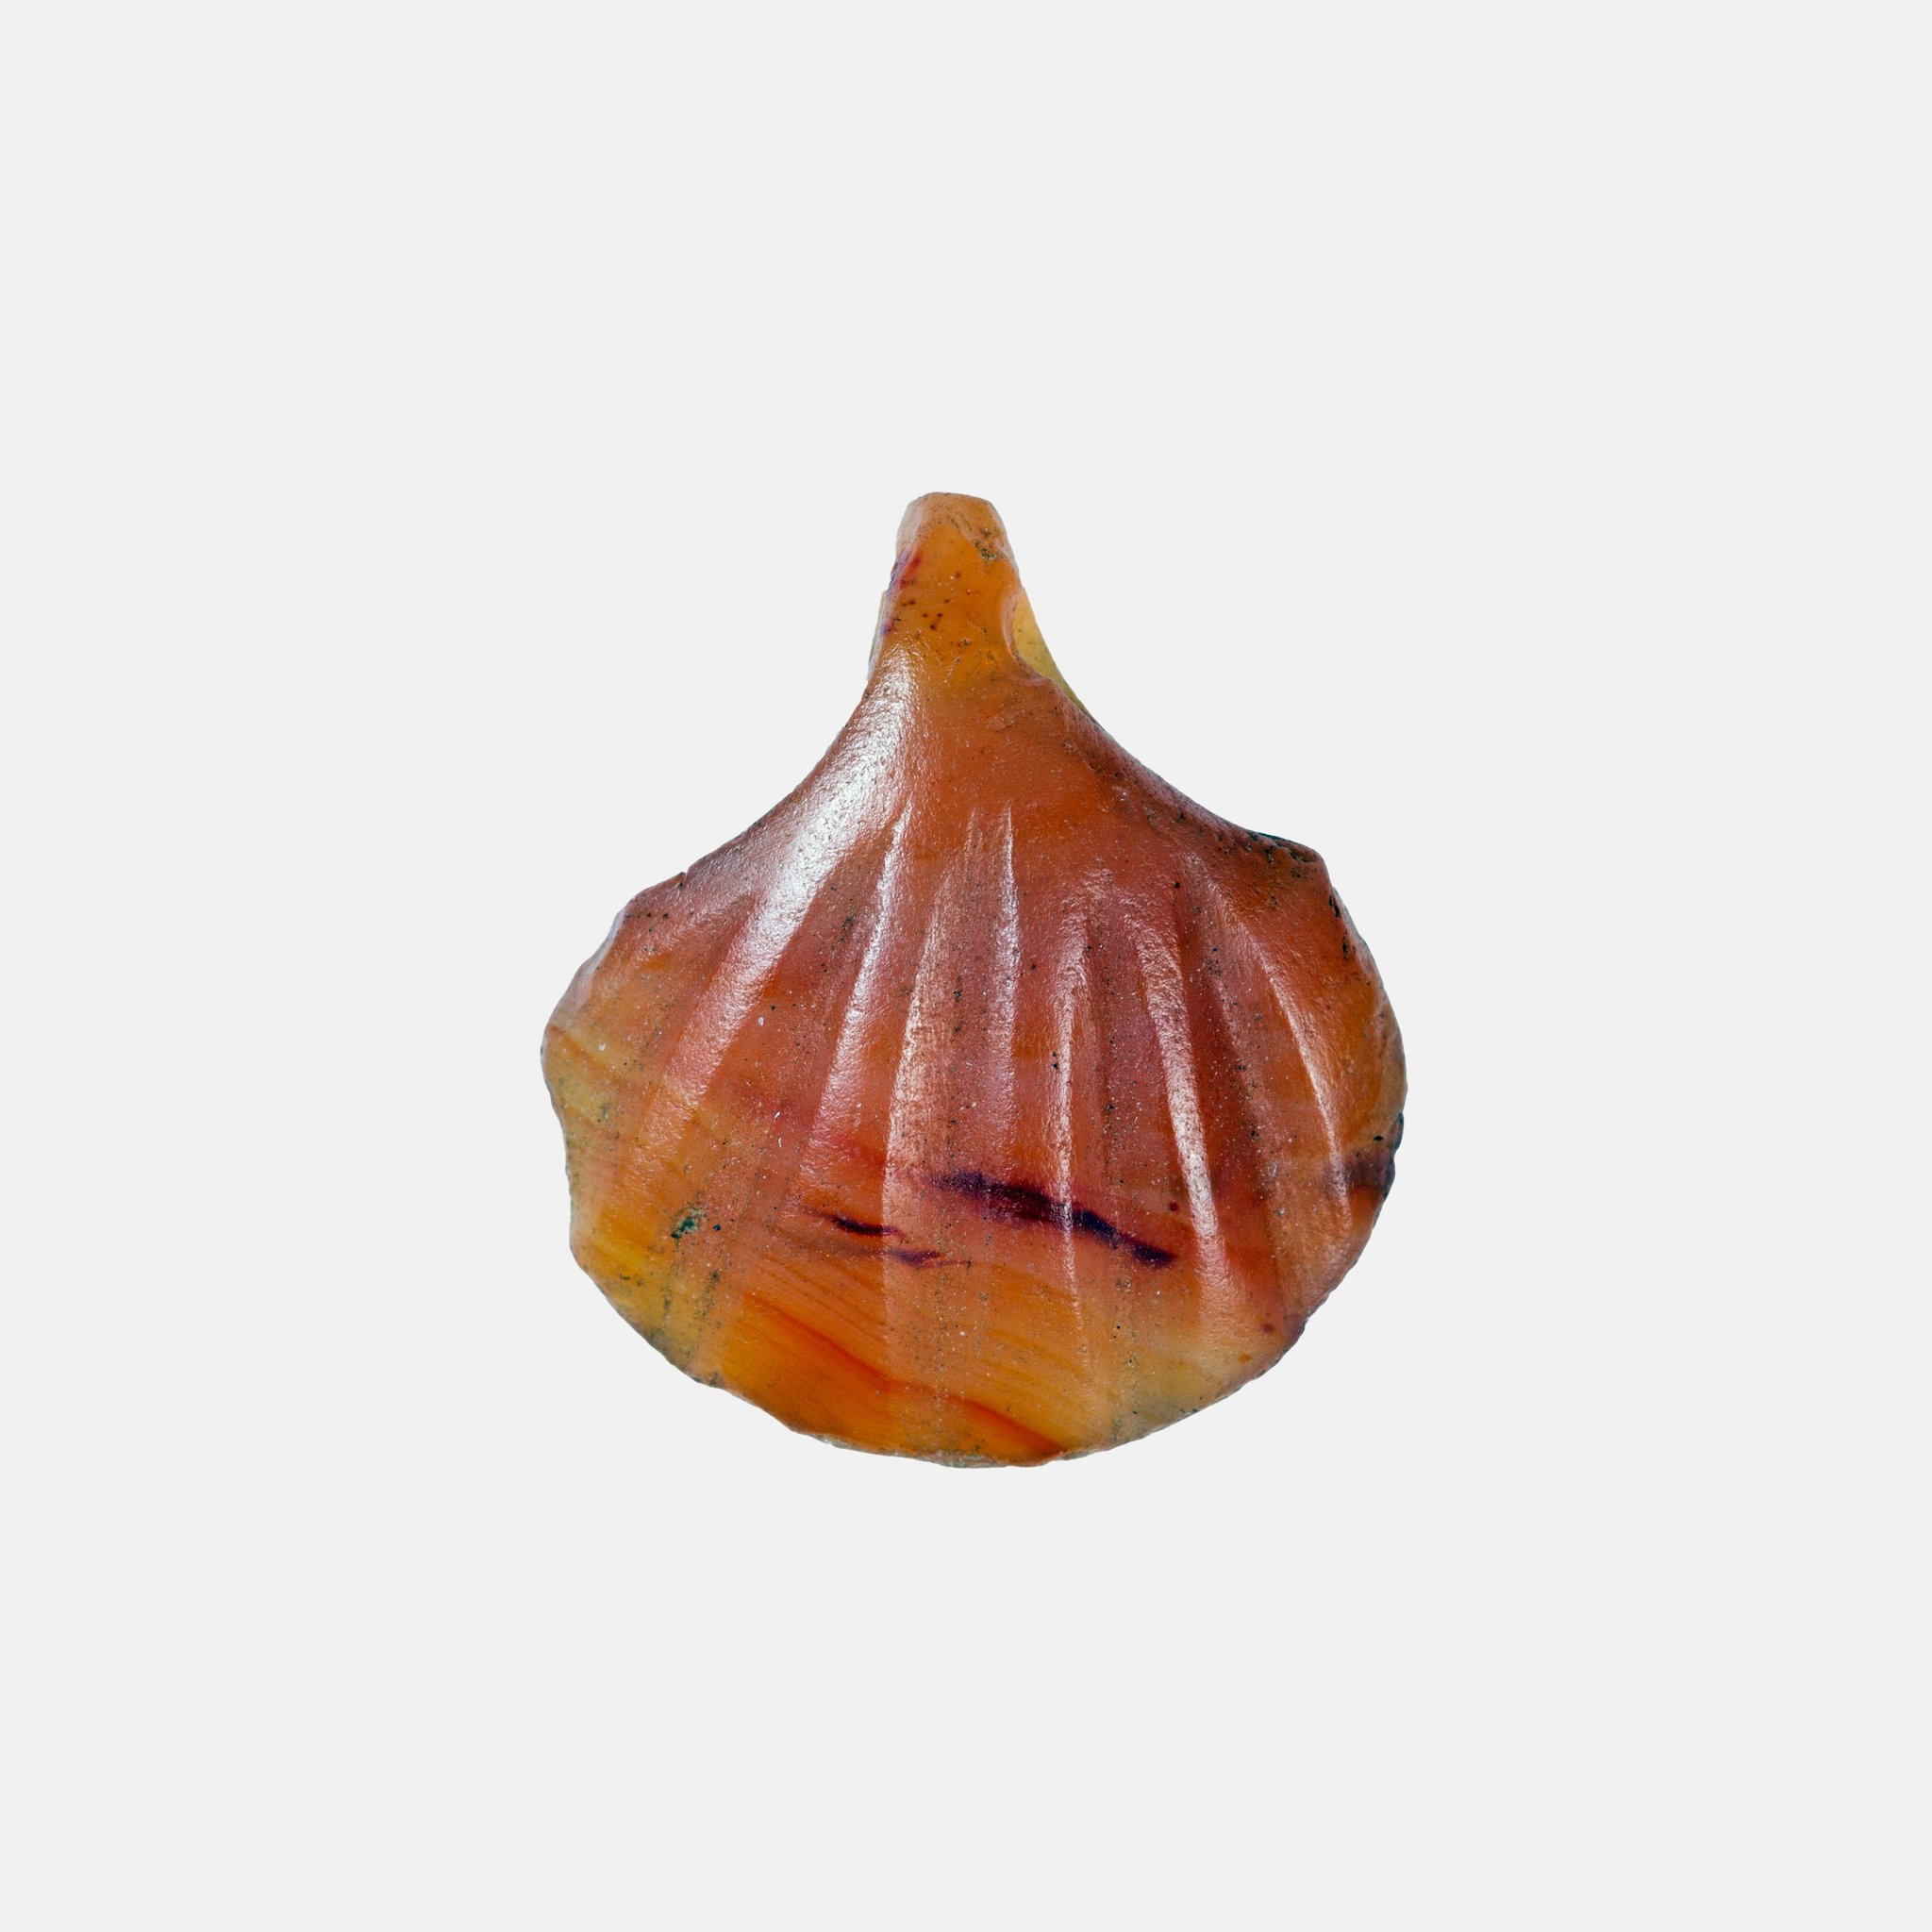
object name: amulet, shell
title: Shell Amulet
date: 2649-2100 BCE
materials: gemstone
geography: egypt